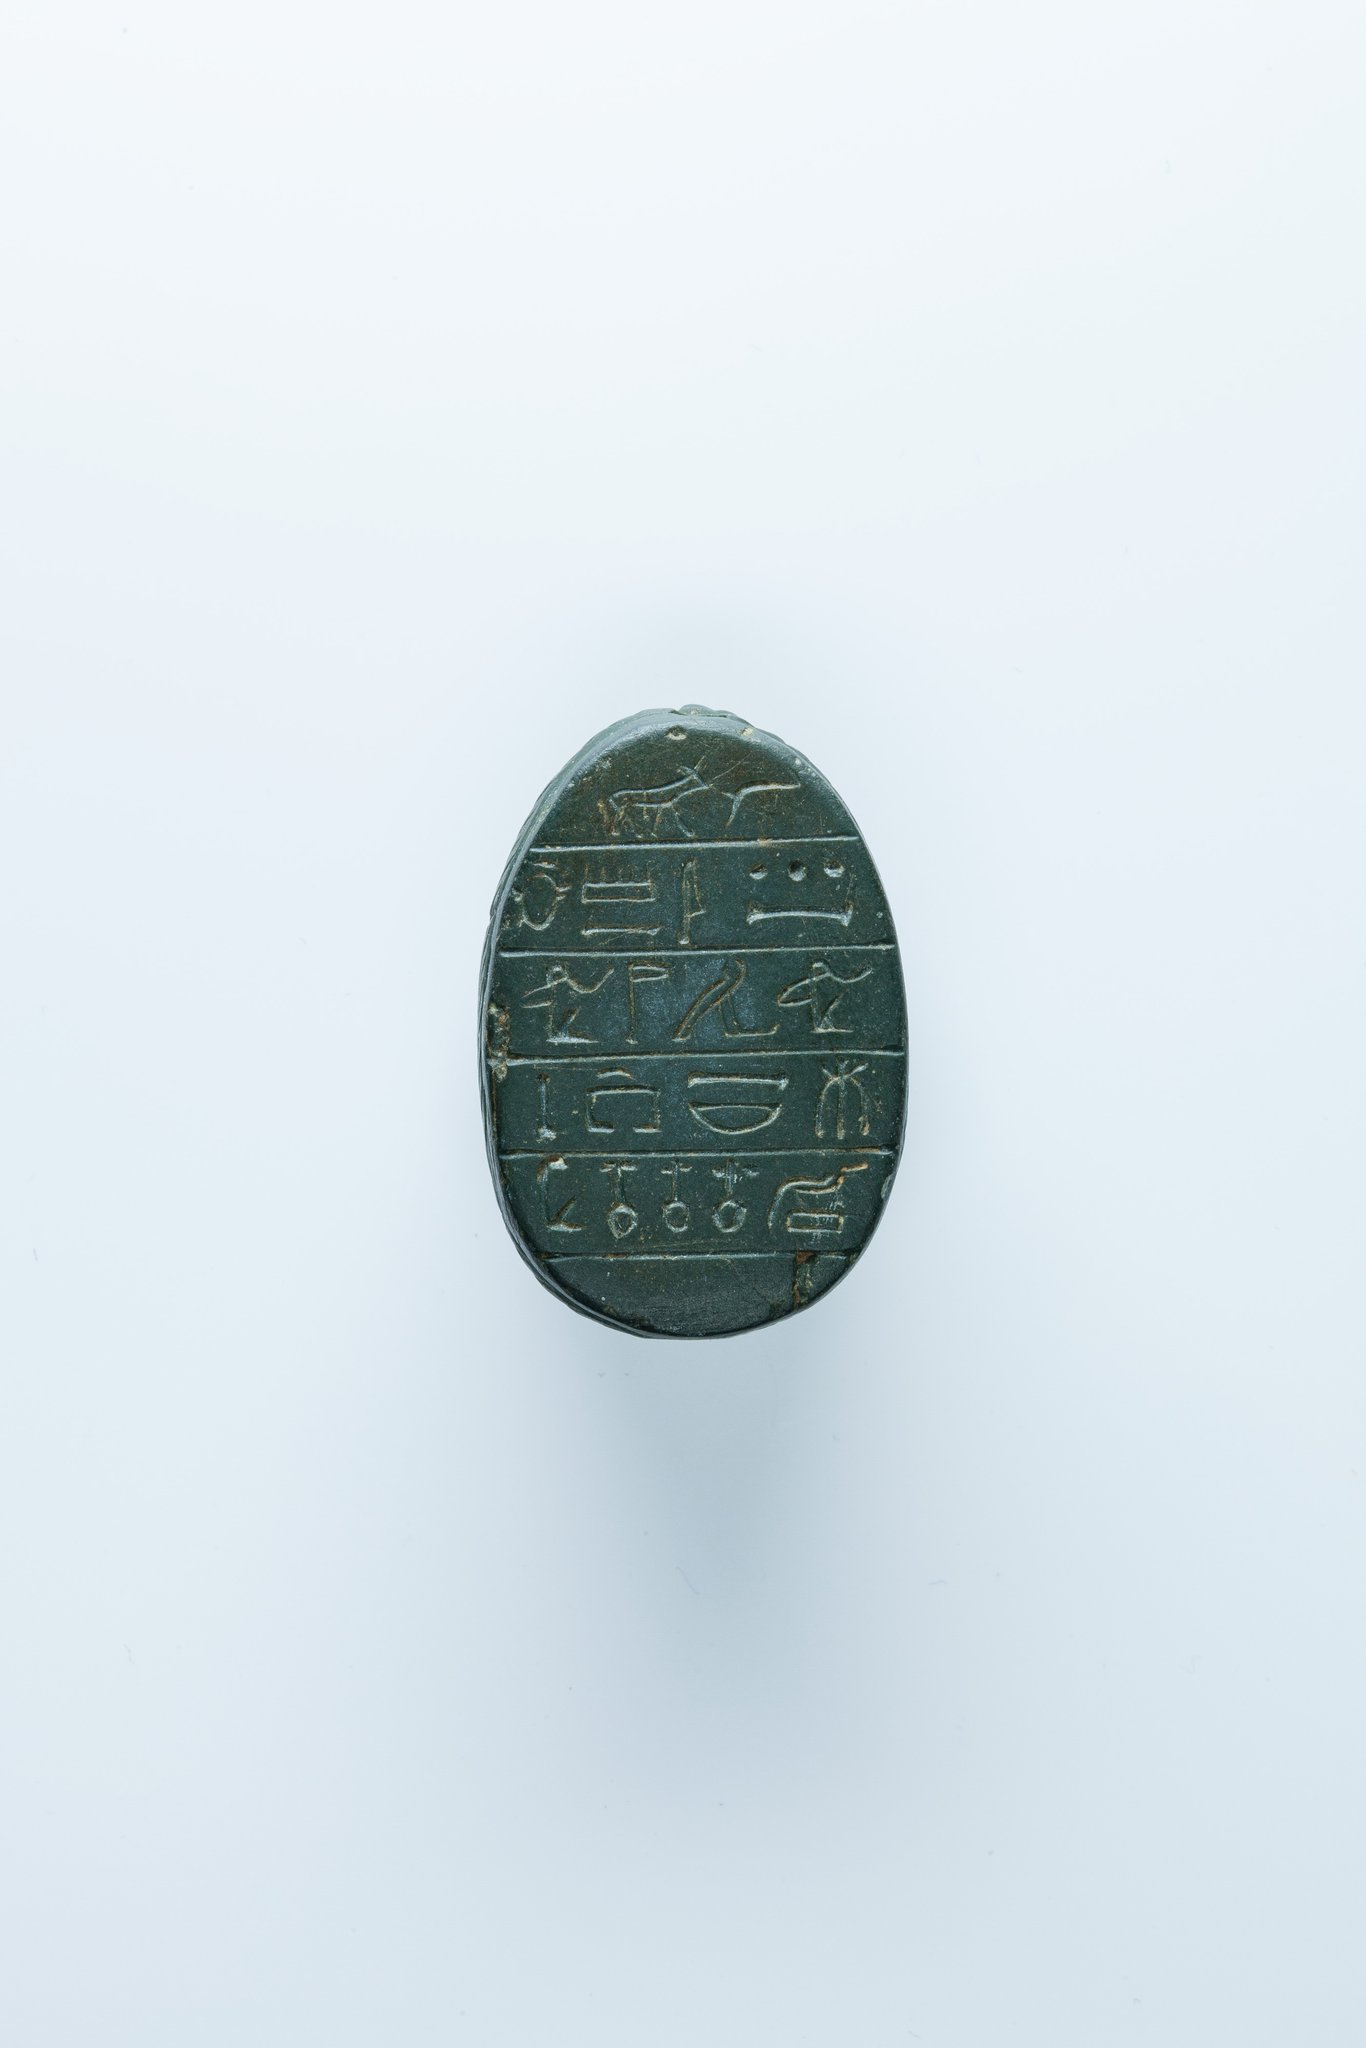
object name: heart scarab, ibemnetjer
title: Heart Scarab of Ibemnetjer ?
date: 1550-1070 BCE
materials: stone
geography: egypt